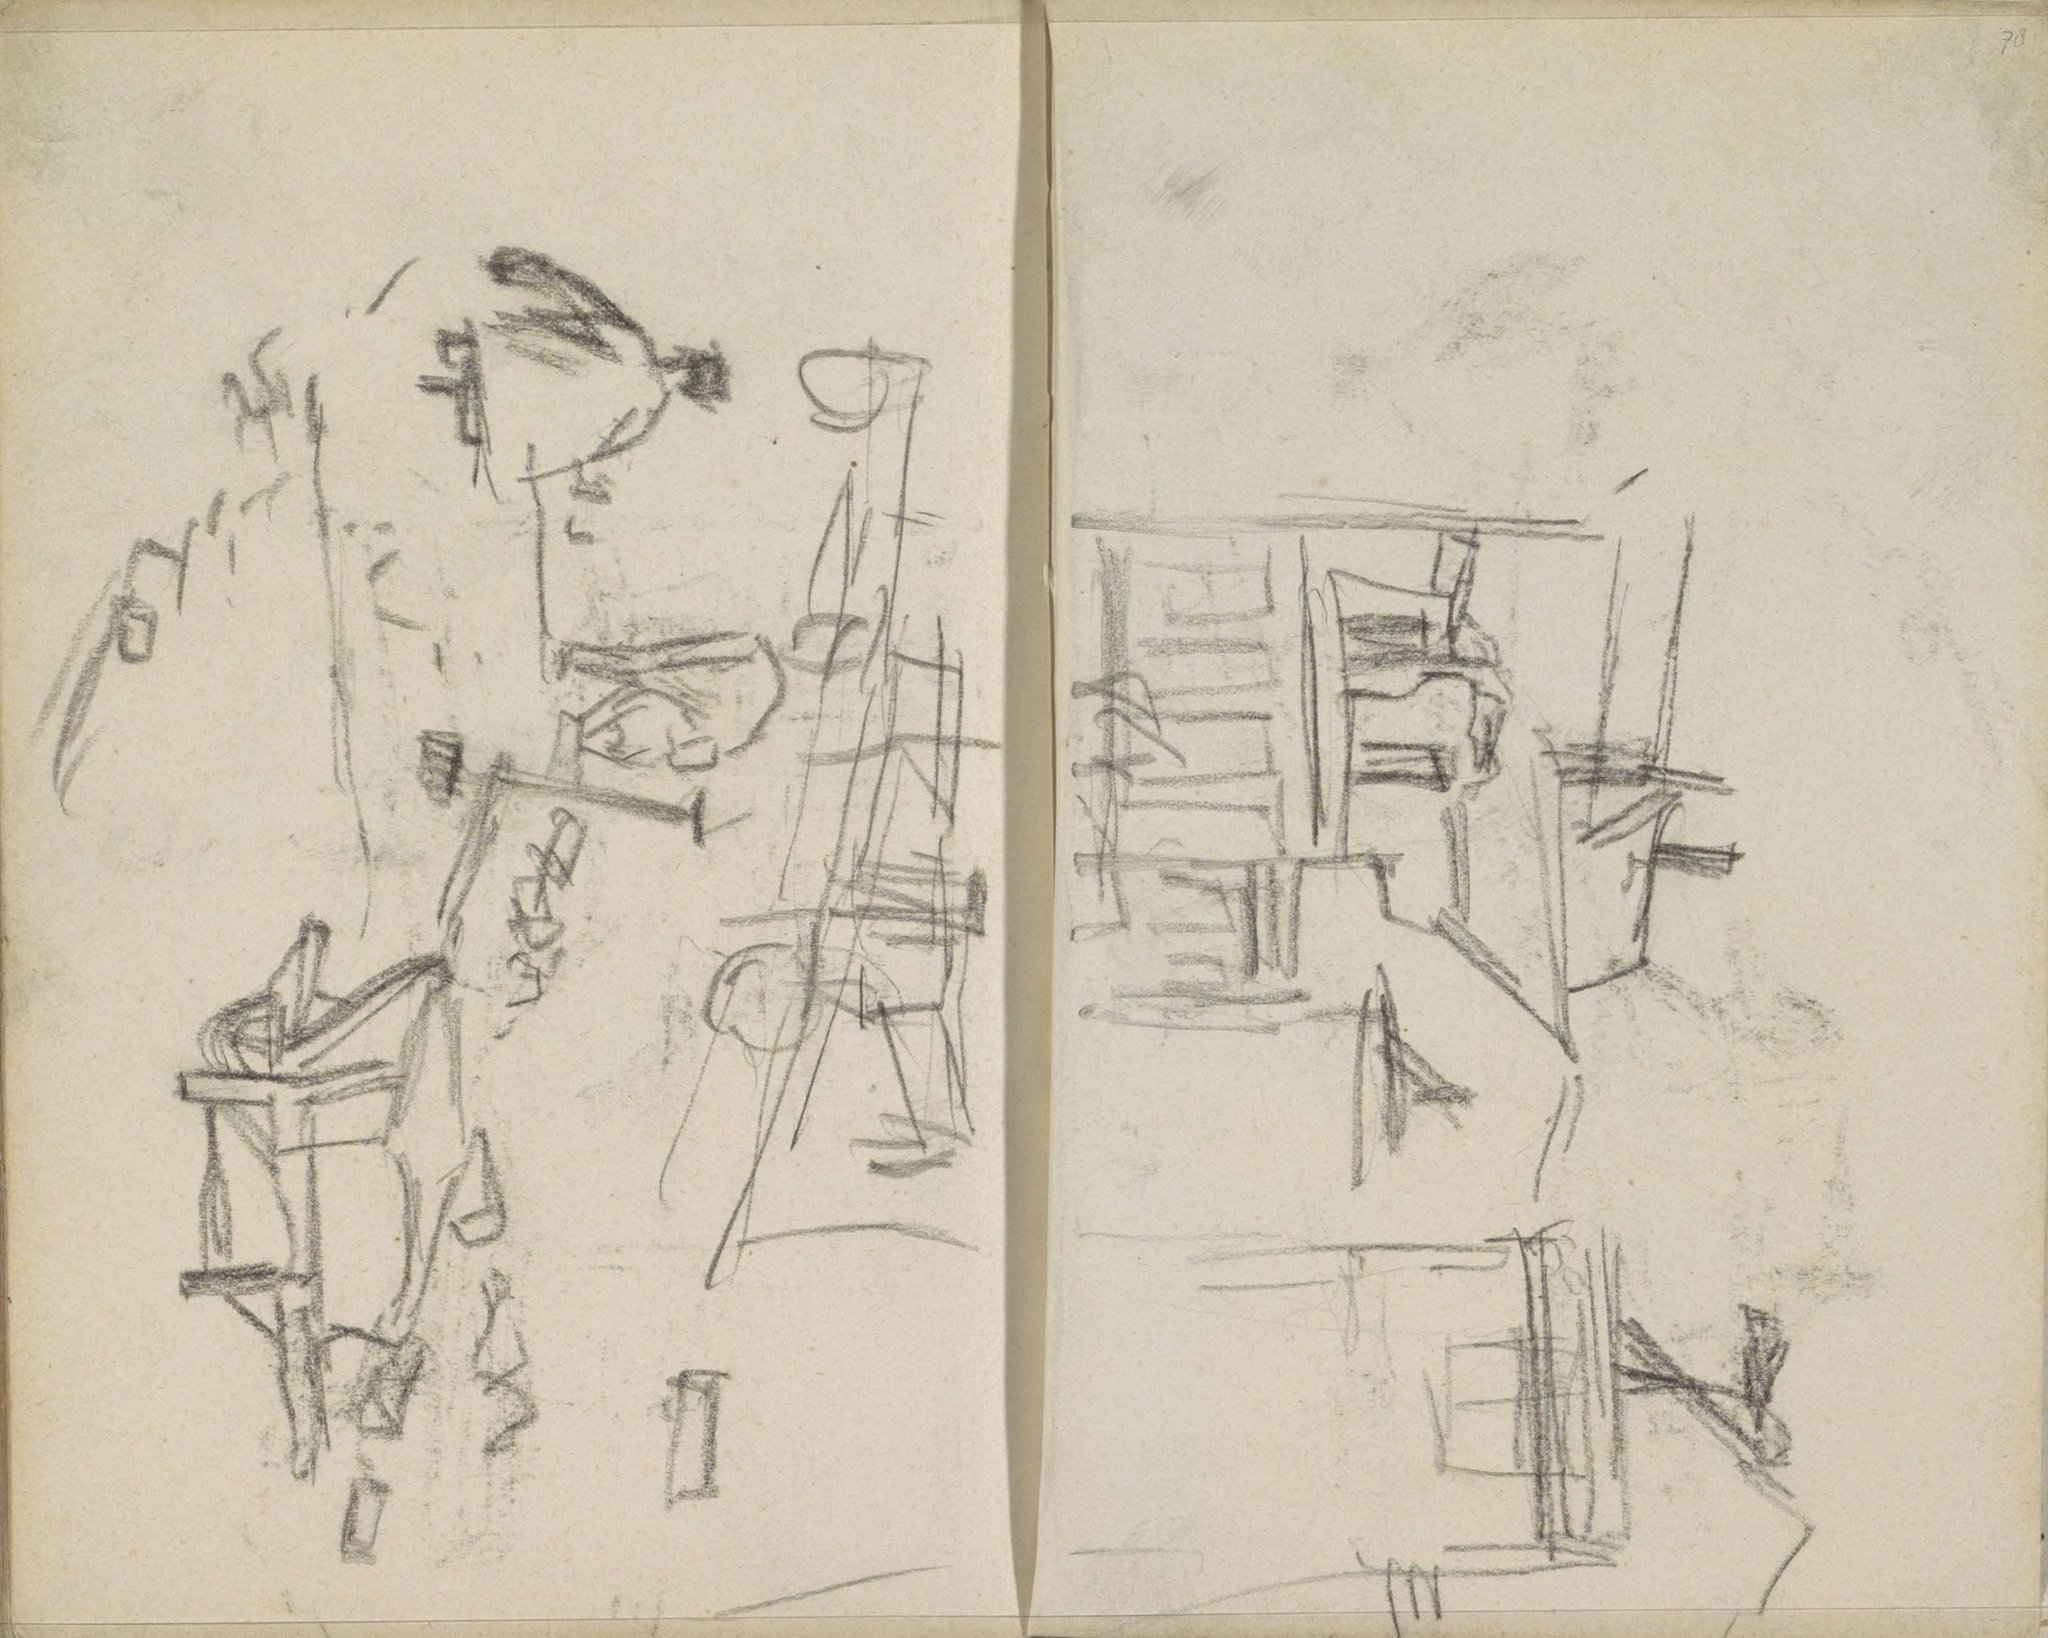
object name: sketchbook leaf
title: Stratenmakers aan het werk in de Overtoom te Amsterdam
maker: george hendrik breitner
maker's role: draughtsman, painter, print maker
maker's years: 1857-1923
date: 1900-1923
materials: chalk, paper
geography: amsterdam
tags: urban housing, working class, labourers, street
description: Vooraan een handkar. Pagina 77 en pagina 78 uit een schetsboek met 39 bladen.